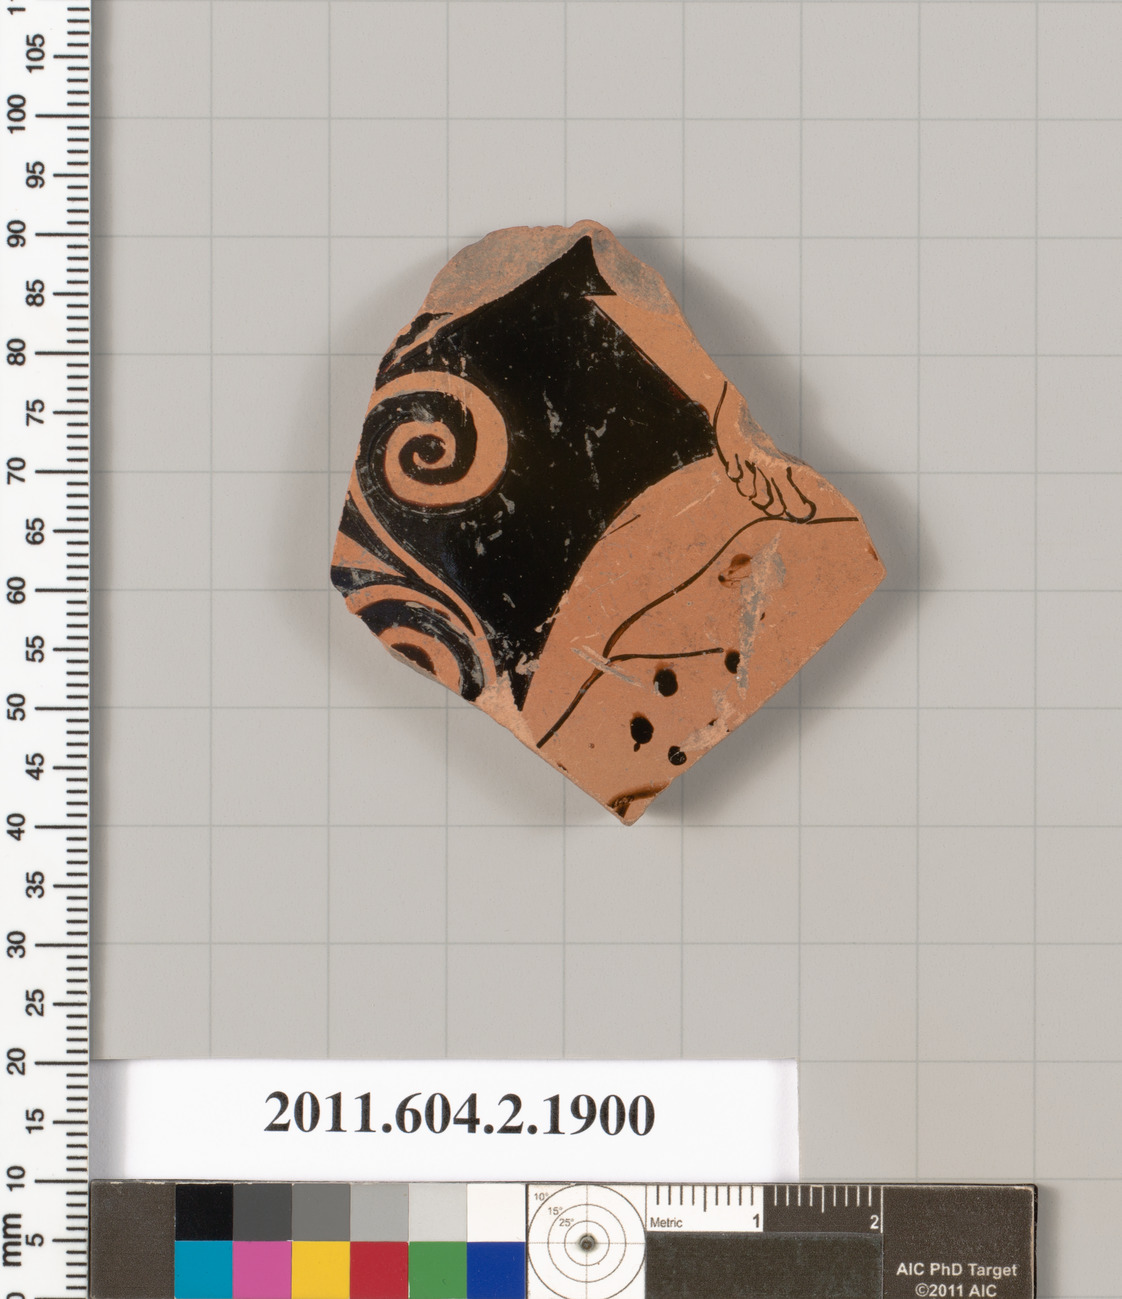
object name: skyphos fragment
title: Terracotta fragment of a skyphos (deep drinking cup)?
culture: greek, attic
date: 450-426 BCE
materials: terracotta